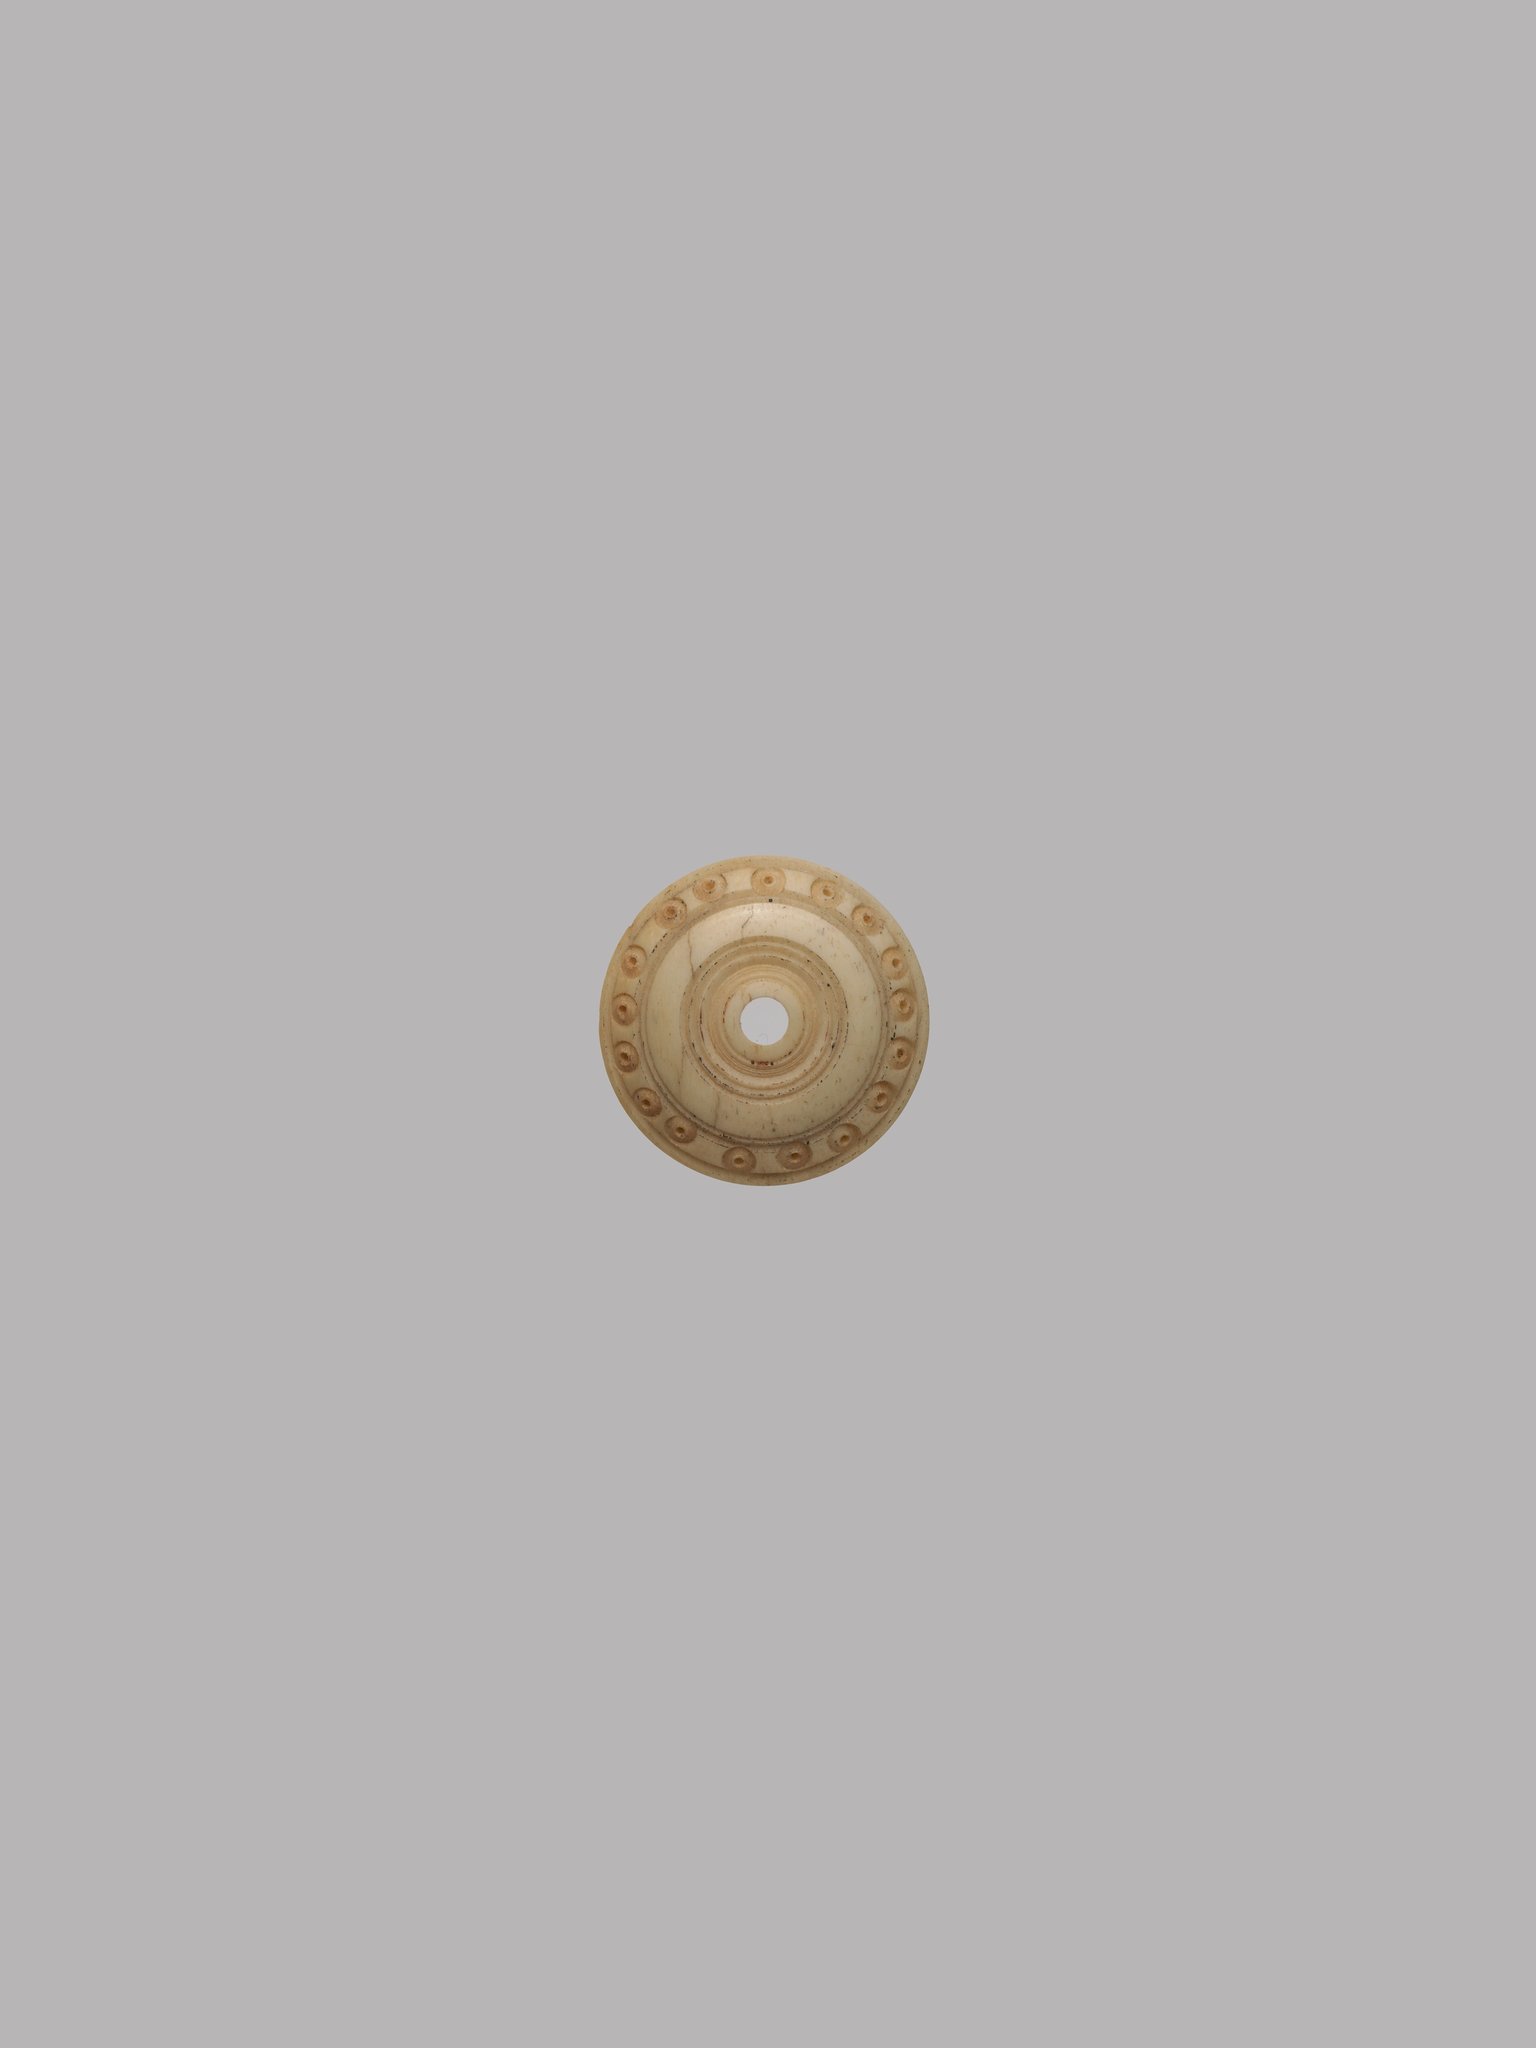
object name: button or bead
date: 801-1000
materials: bone, paint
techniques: incising, inlay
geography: iran